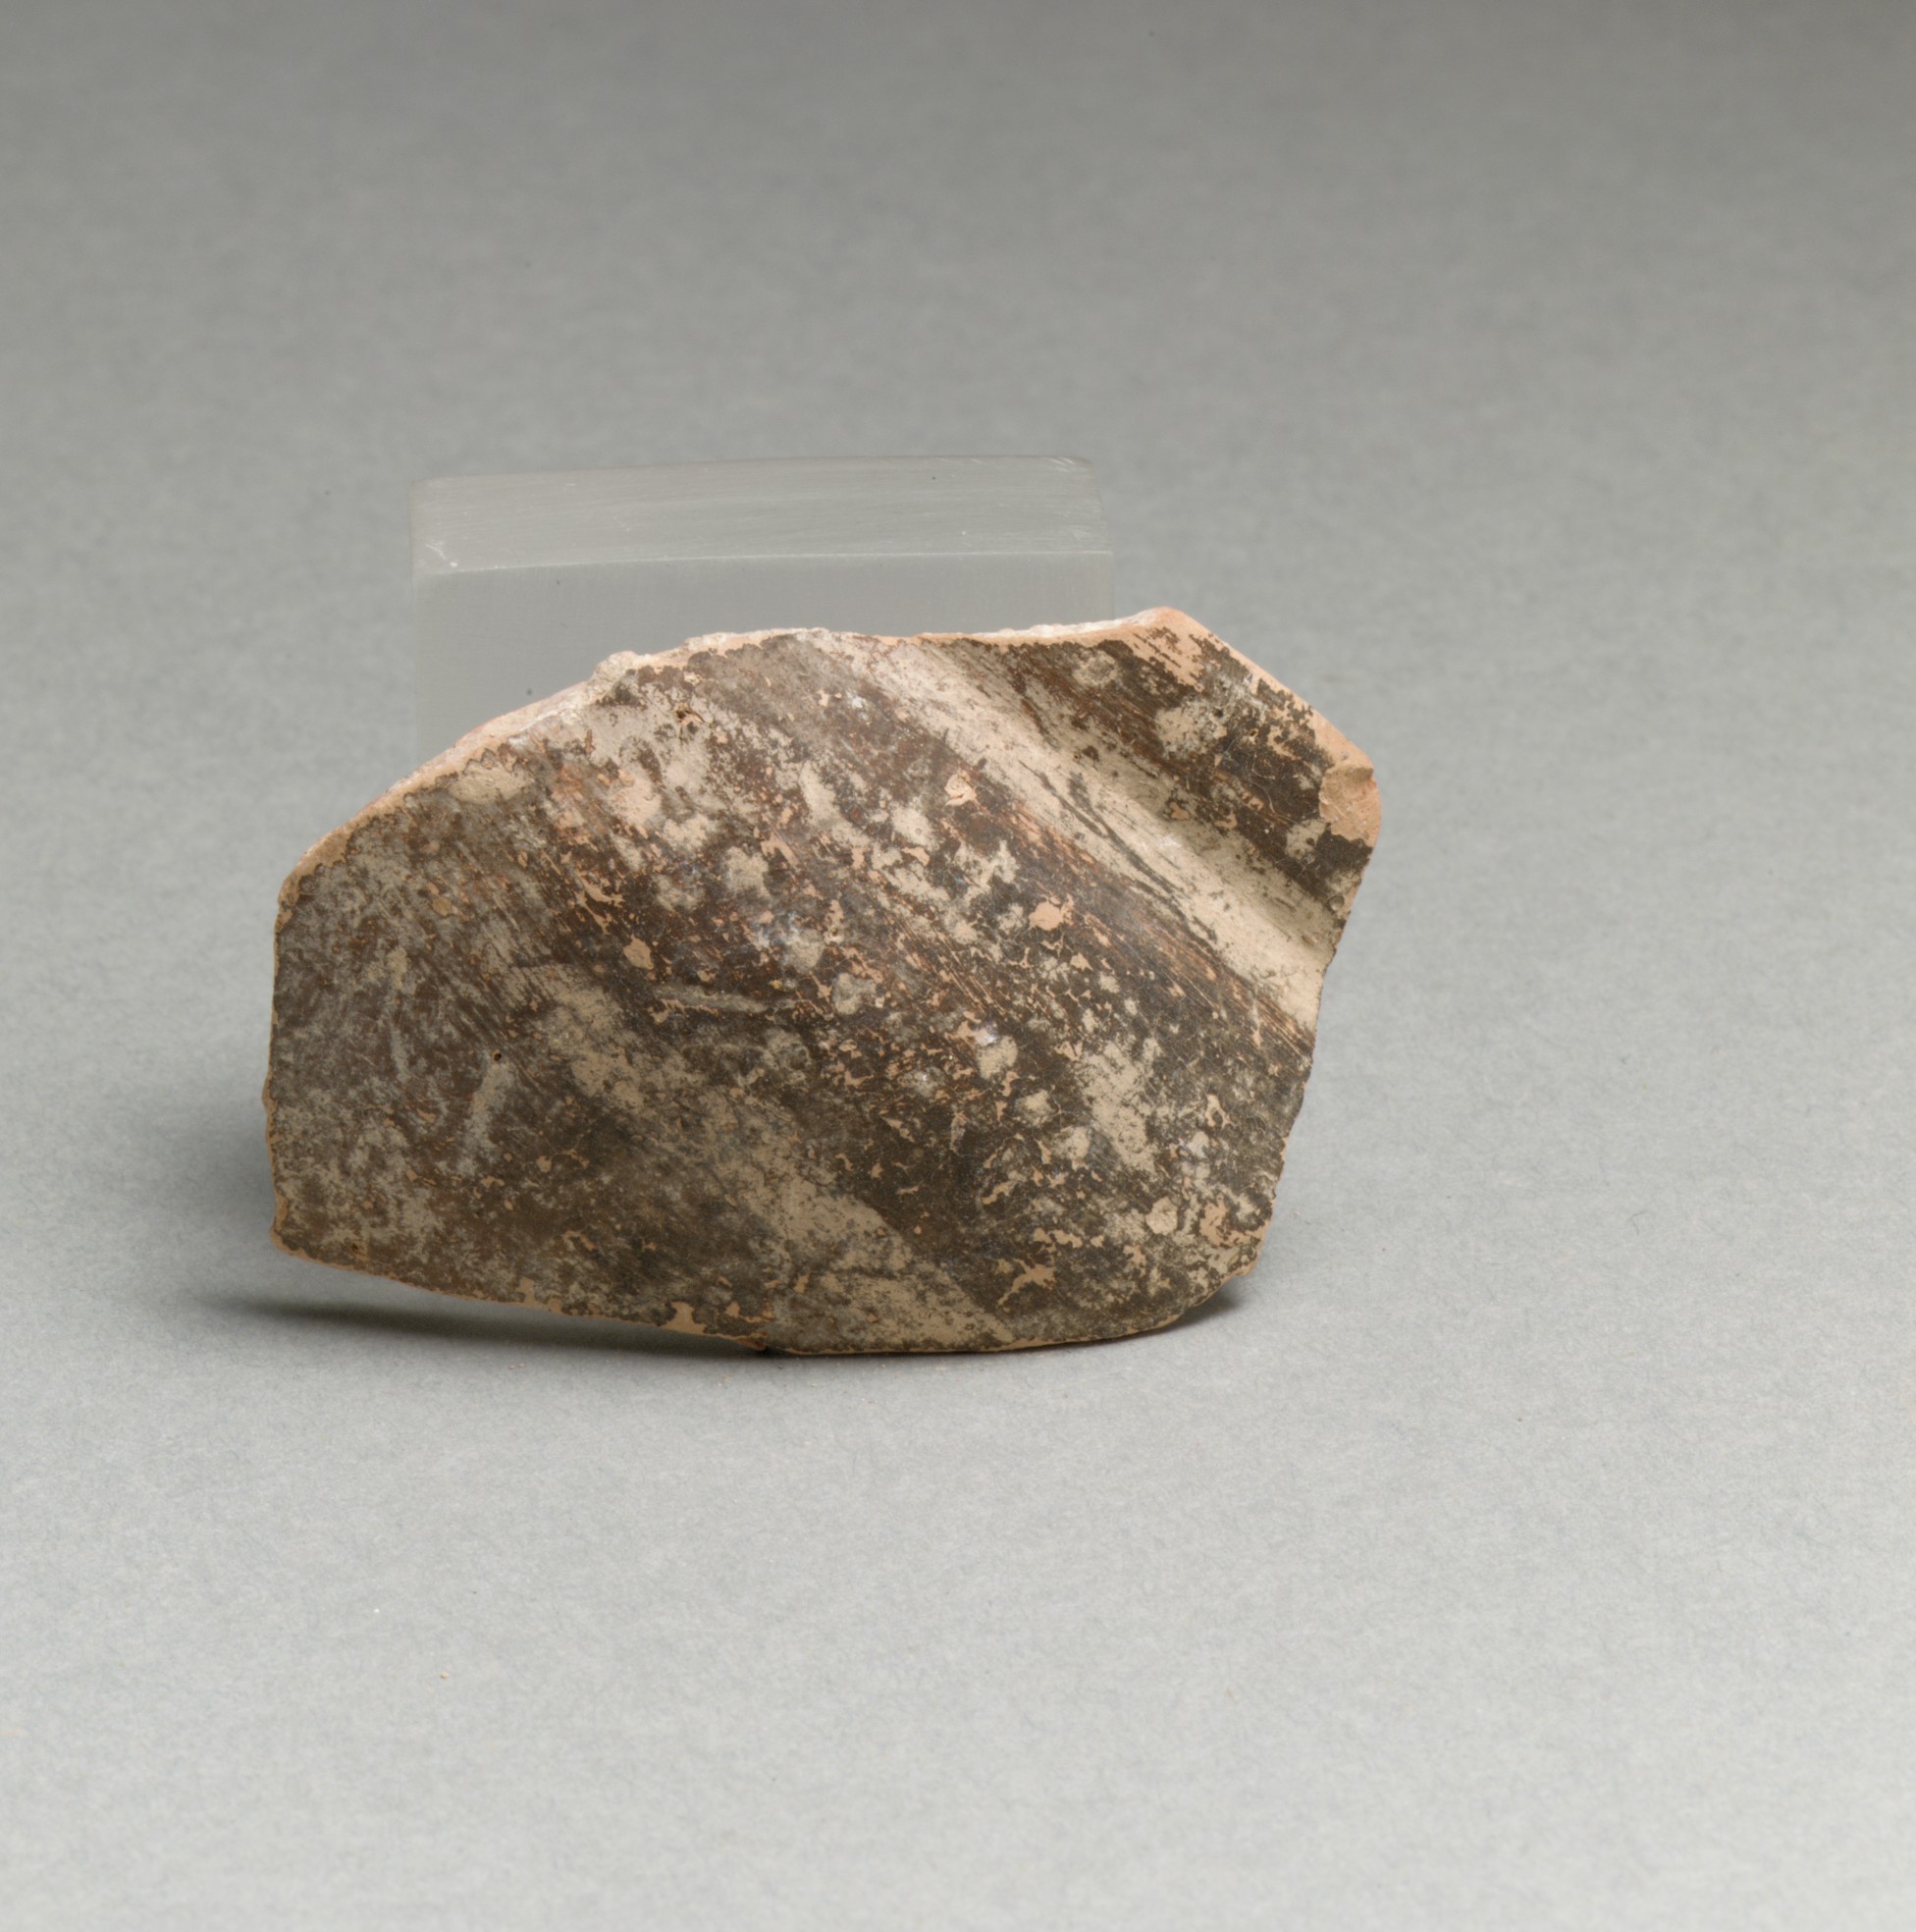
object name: vase fragment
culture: minoan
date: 2600-2000 BCE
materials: terracotta